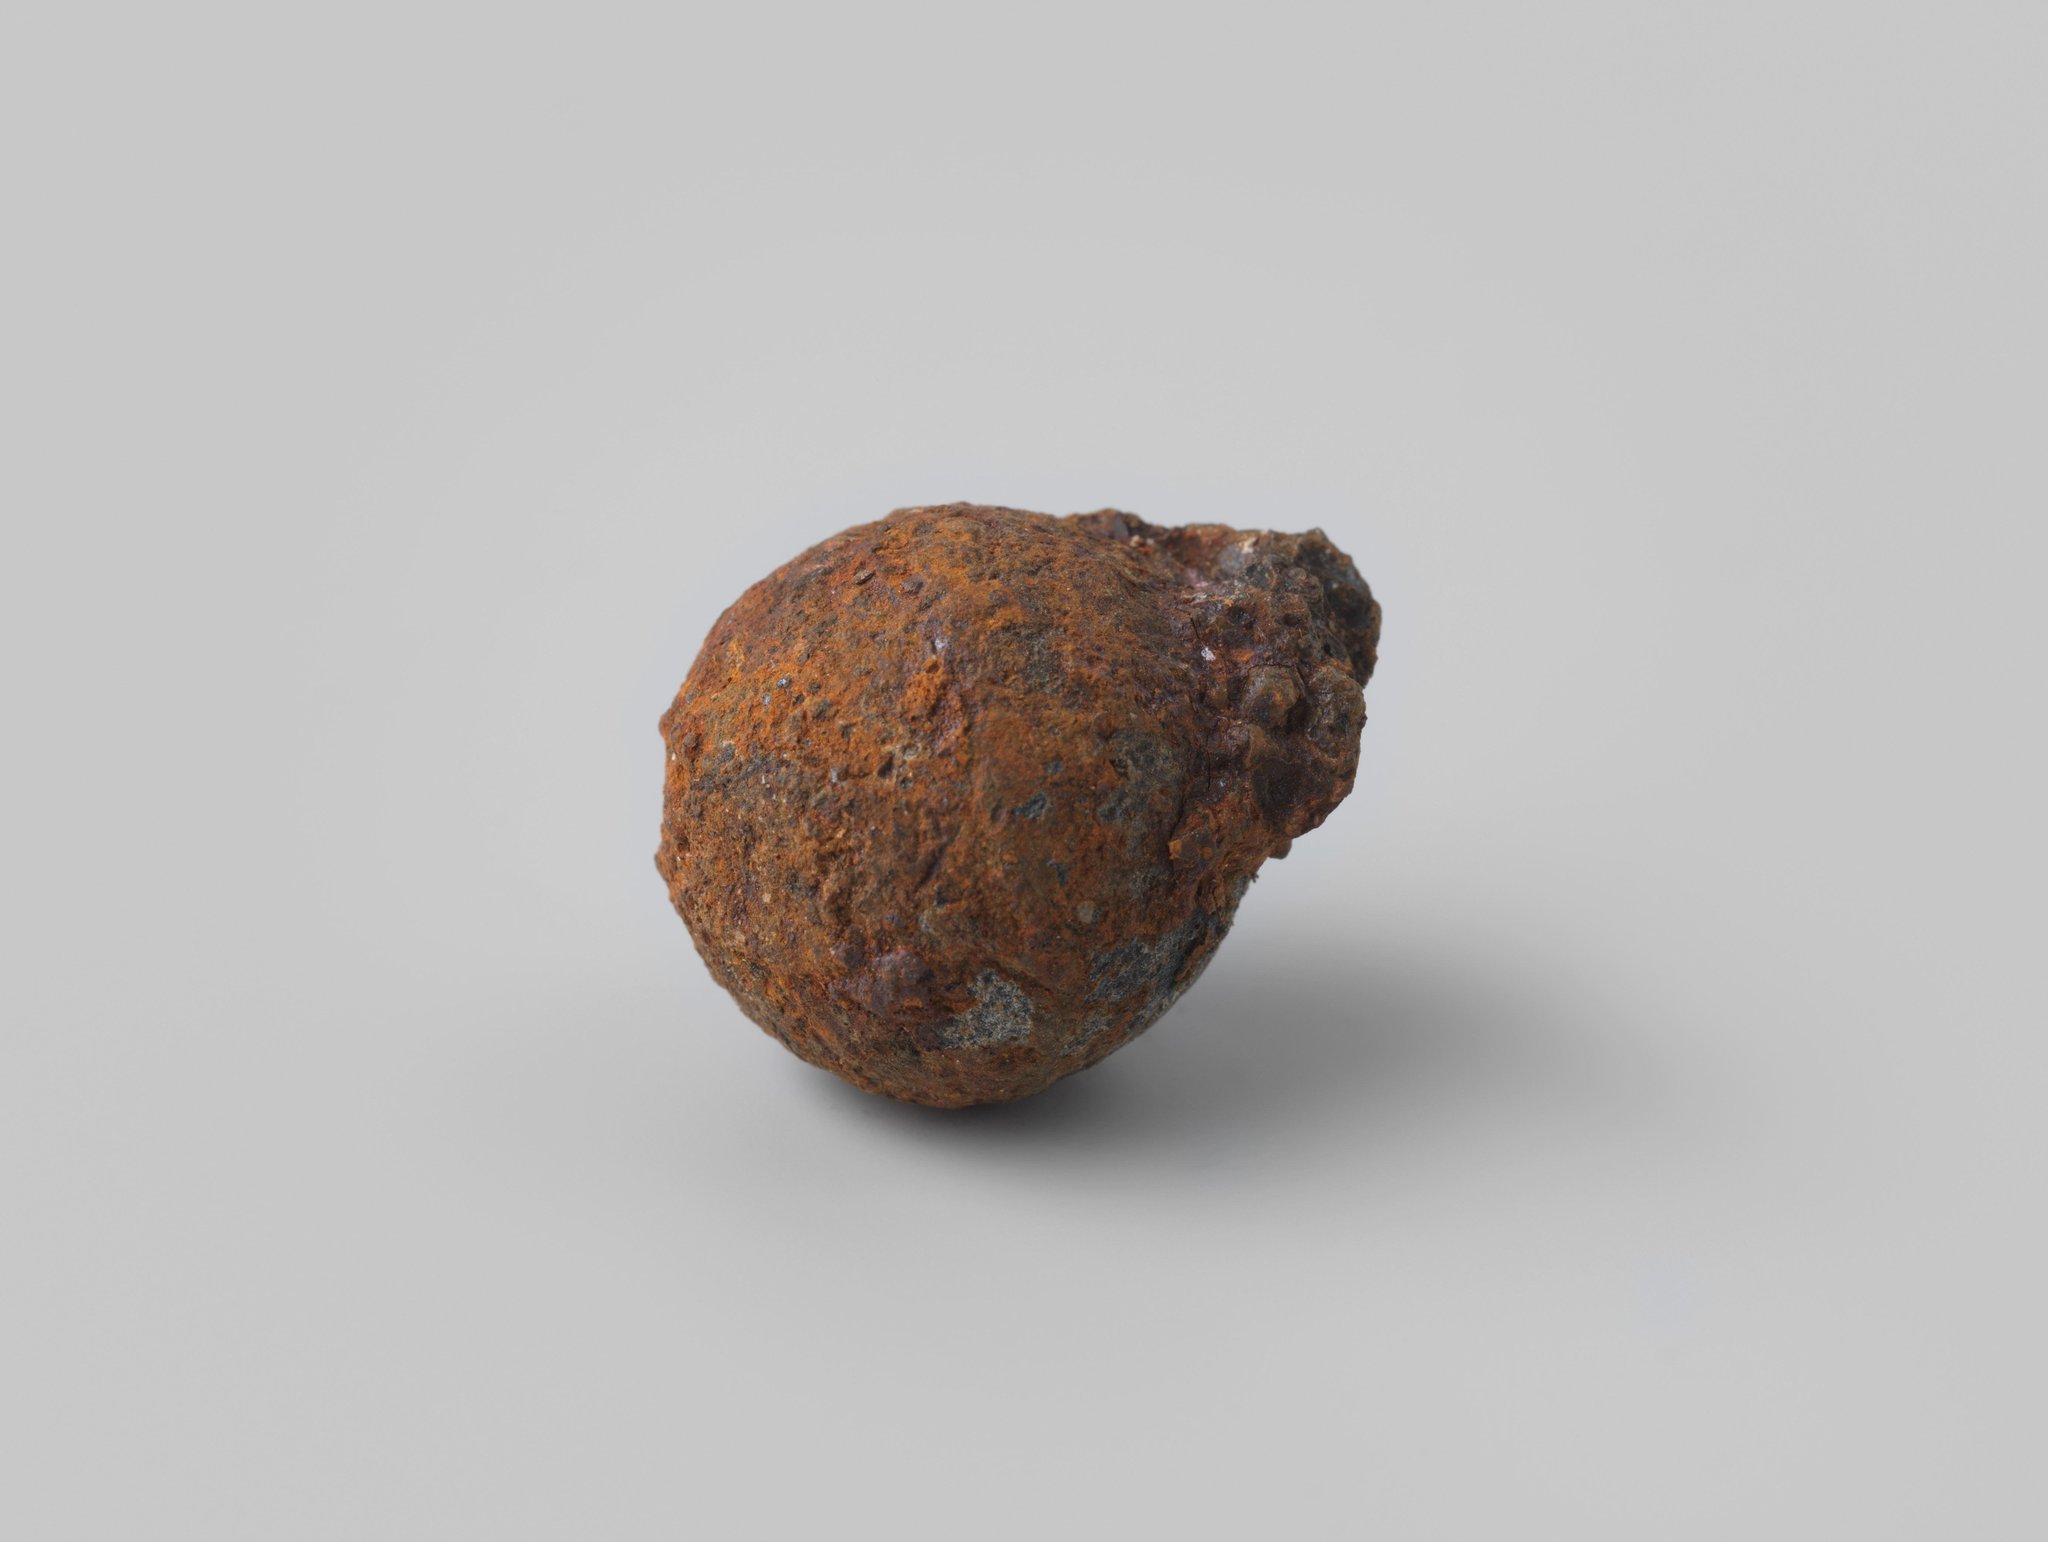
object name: musketkogel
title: Musketkogel met concretie uit het wrak van de Oost-Indiëvaarder Hollandia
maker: Anonymous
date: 1700-1743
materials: stone, lead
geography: netherlands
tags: verenigde oostindische compagnie, hollandia (schip), annet